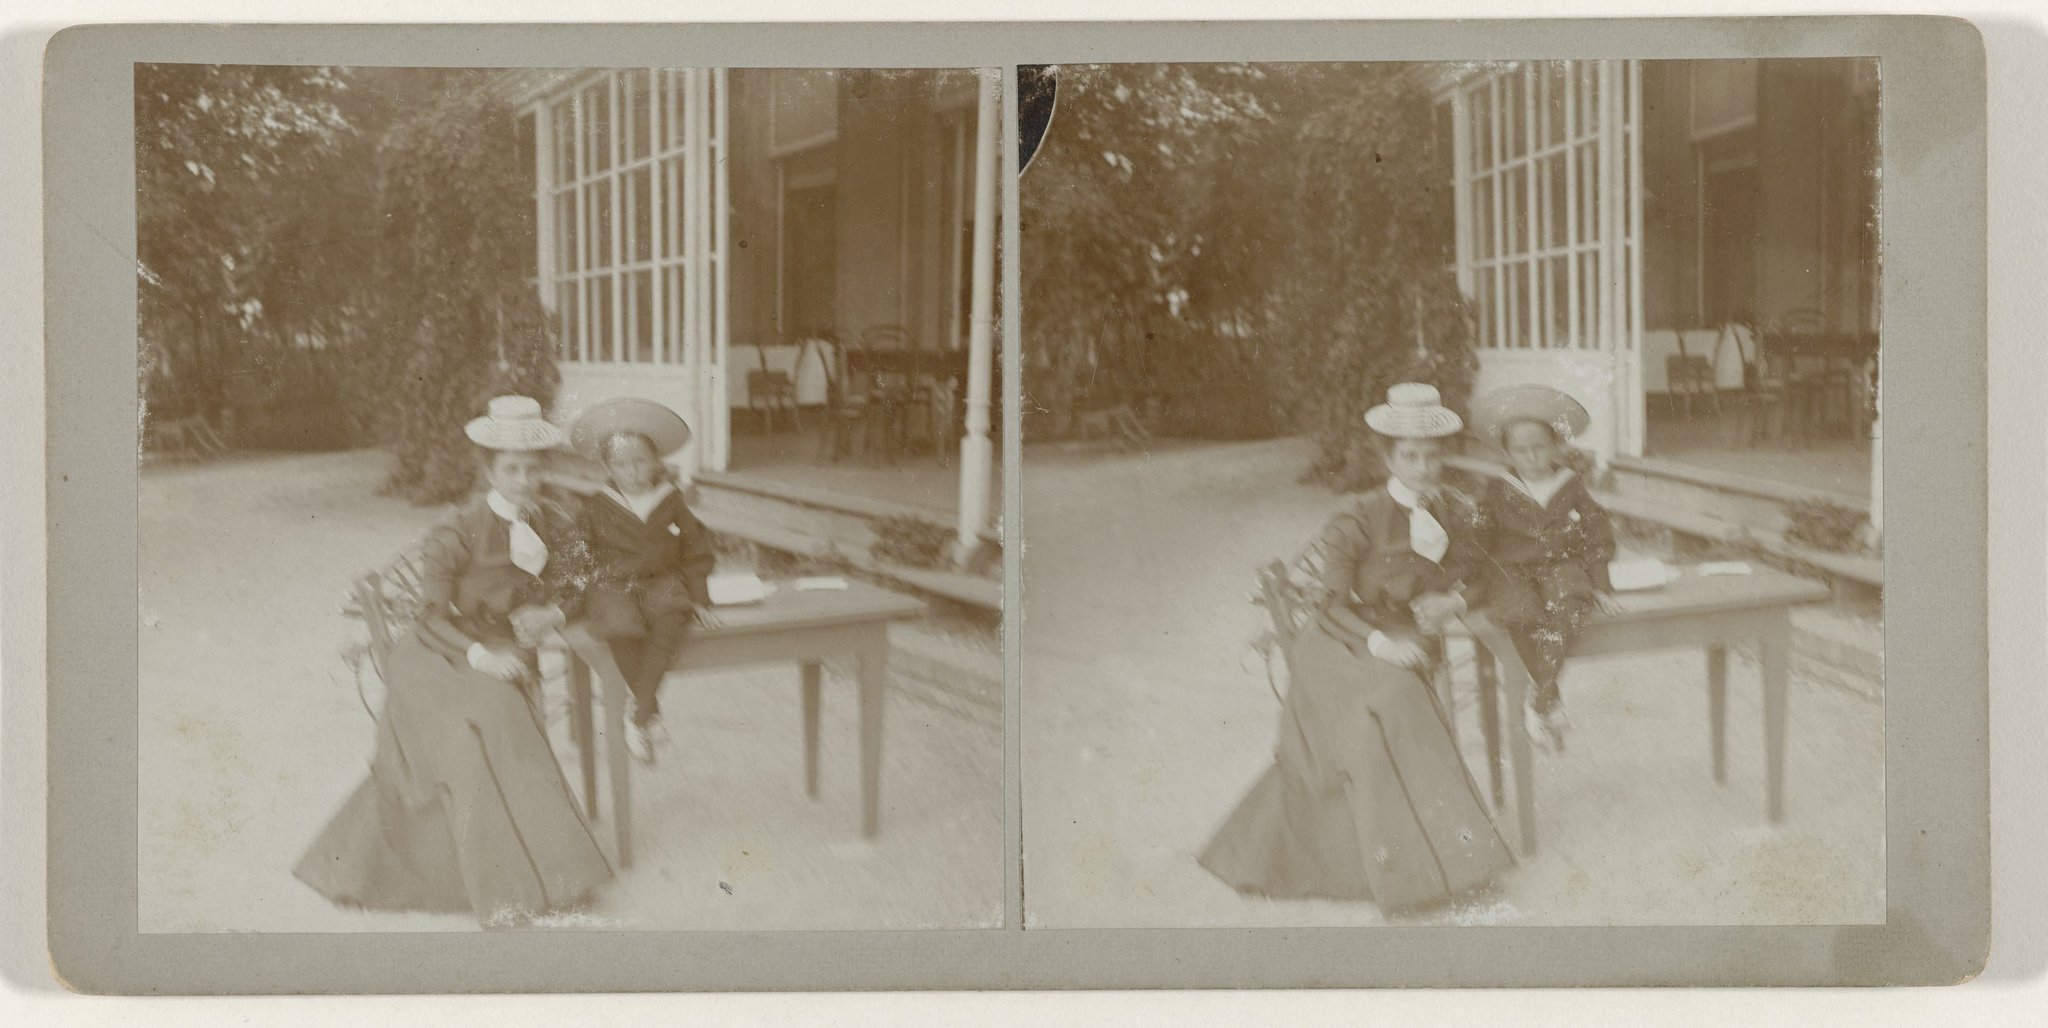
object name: stereograph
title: Portret van een vrouw op een stoel en jongetje in matrozenpak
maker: geldolph adriaan kessler (dolph)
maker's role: fotograaf, industrieel, voetballer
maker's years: 1884-1945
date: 1899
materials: paper, photographic support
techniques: collodion silver print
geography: netherlands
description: Vrouw en kind zijn vermoedleijk leden van de familie Kessler.